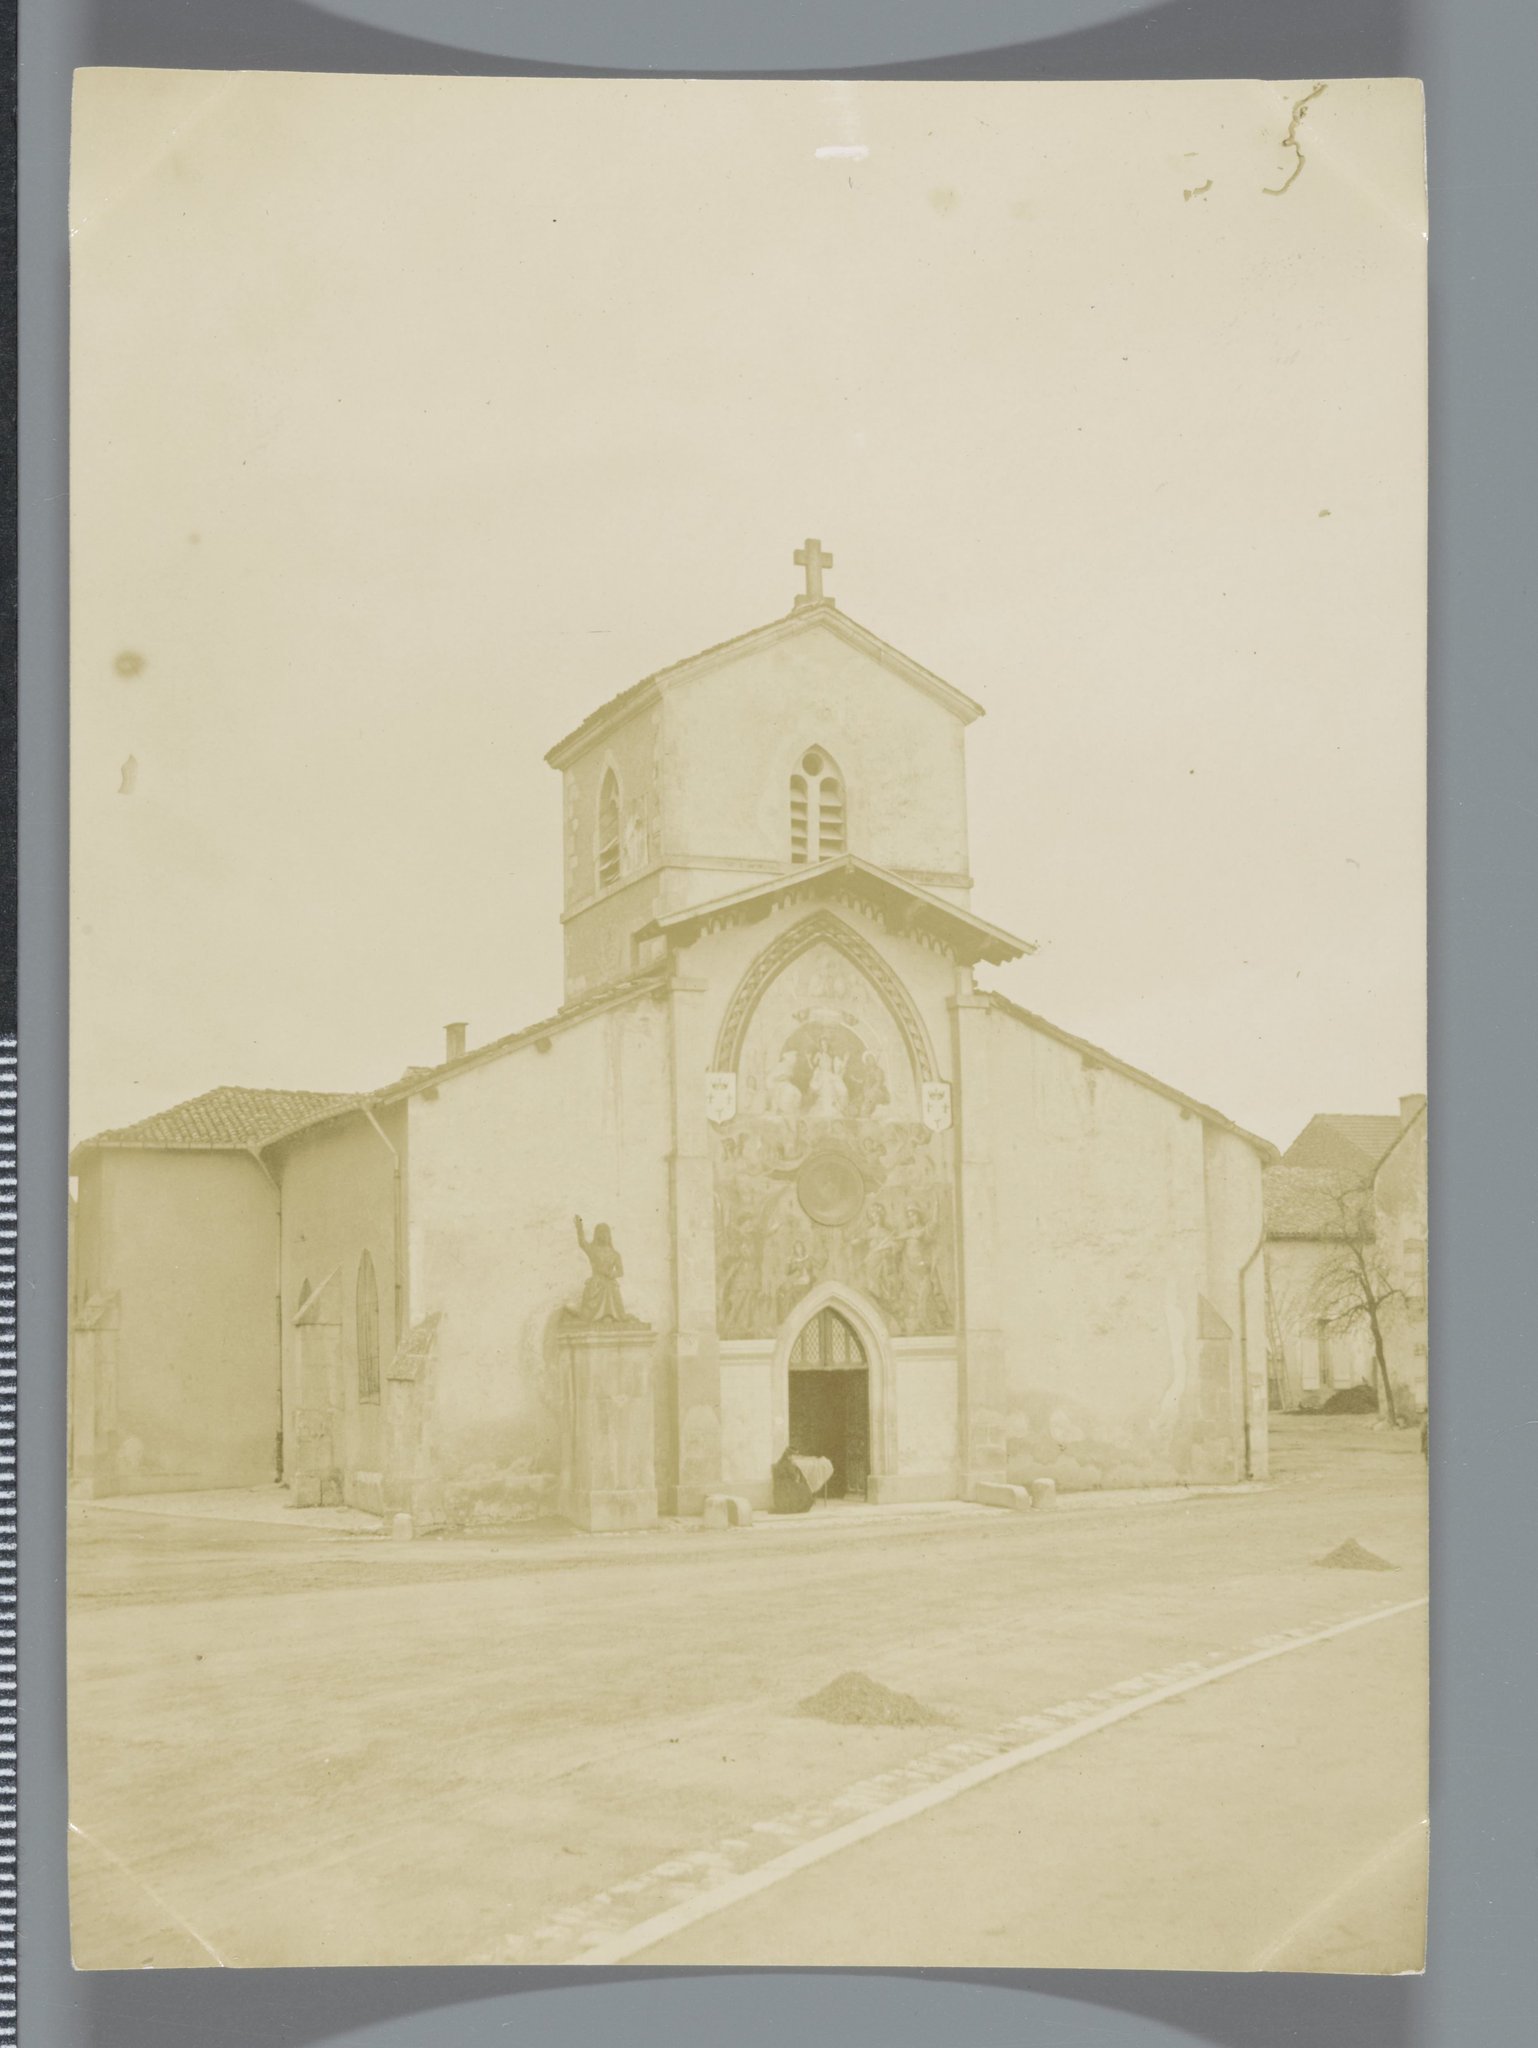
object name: photograph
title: De kerk van Domrémy-la-Pucelle (de geboortestad van Jeanne d’Arc), Frankrijk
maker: Anonymous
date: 1900-1903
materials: paper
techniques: gelatin silver print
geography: france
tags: church (exterior), france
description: De kerk van Domrémy-la-Pucelle (de geboortestad van Jeanne d’Arc), Frankrijk.